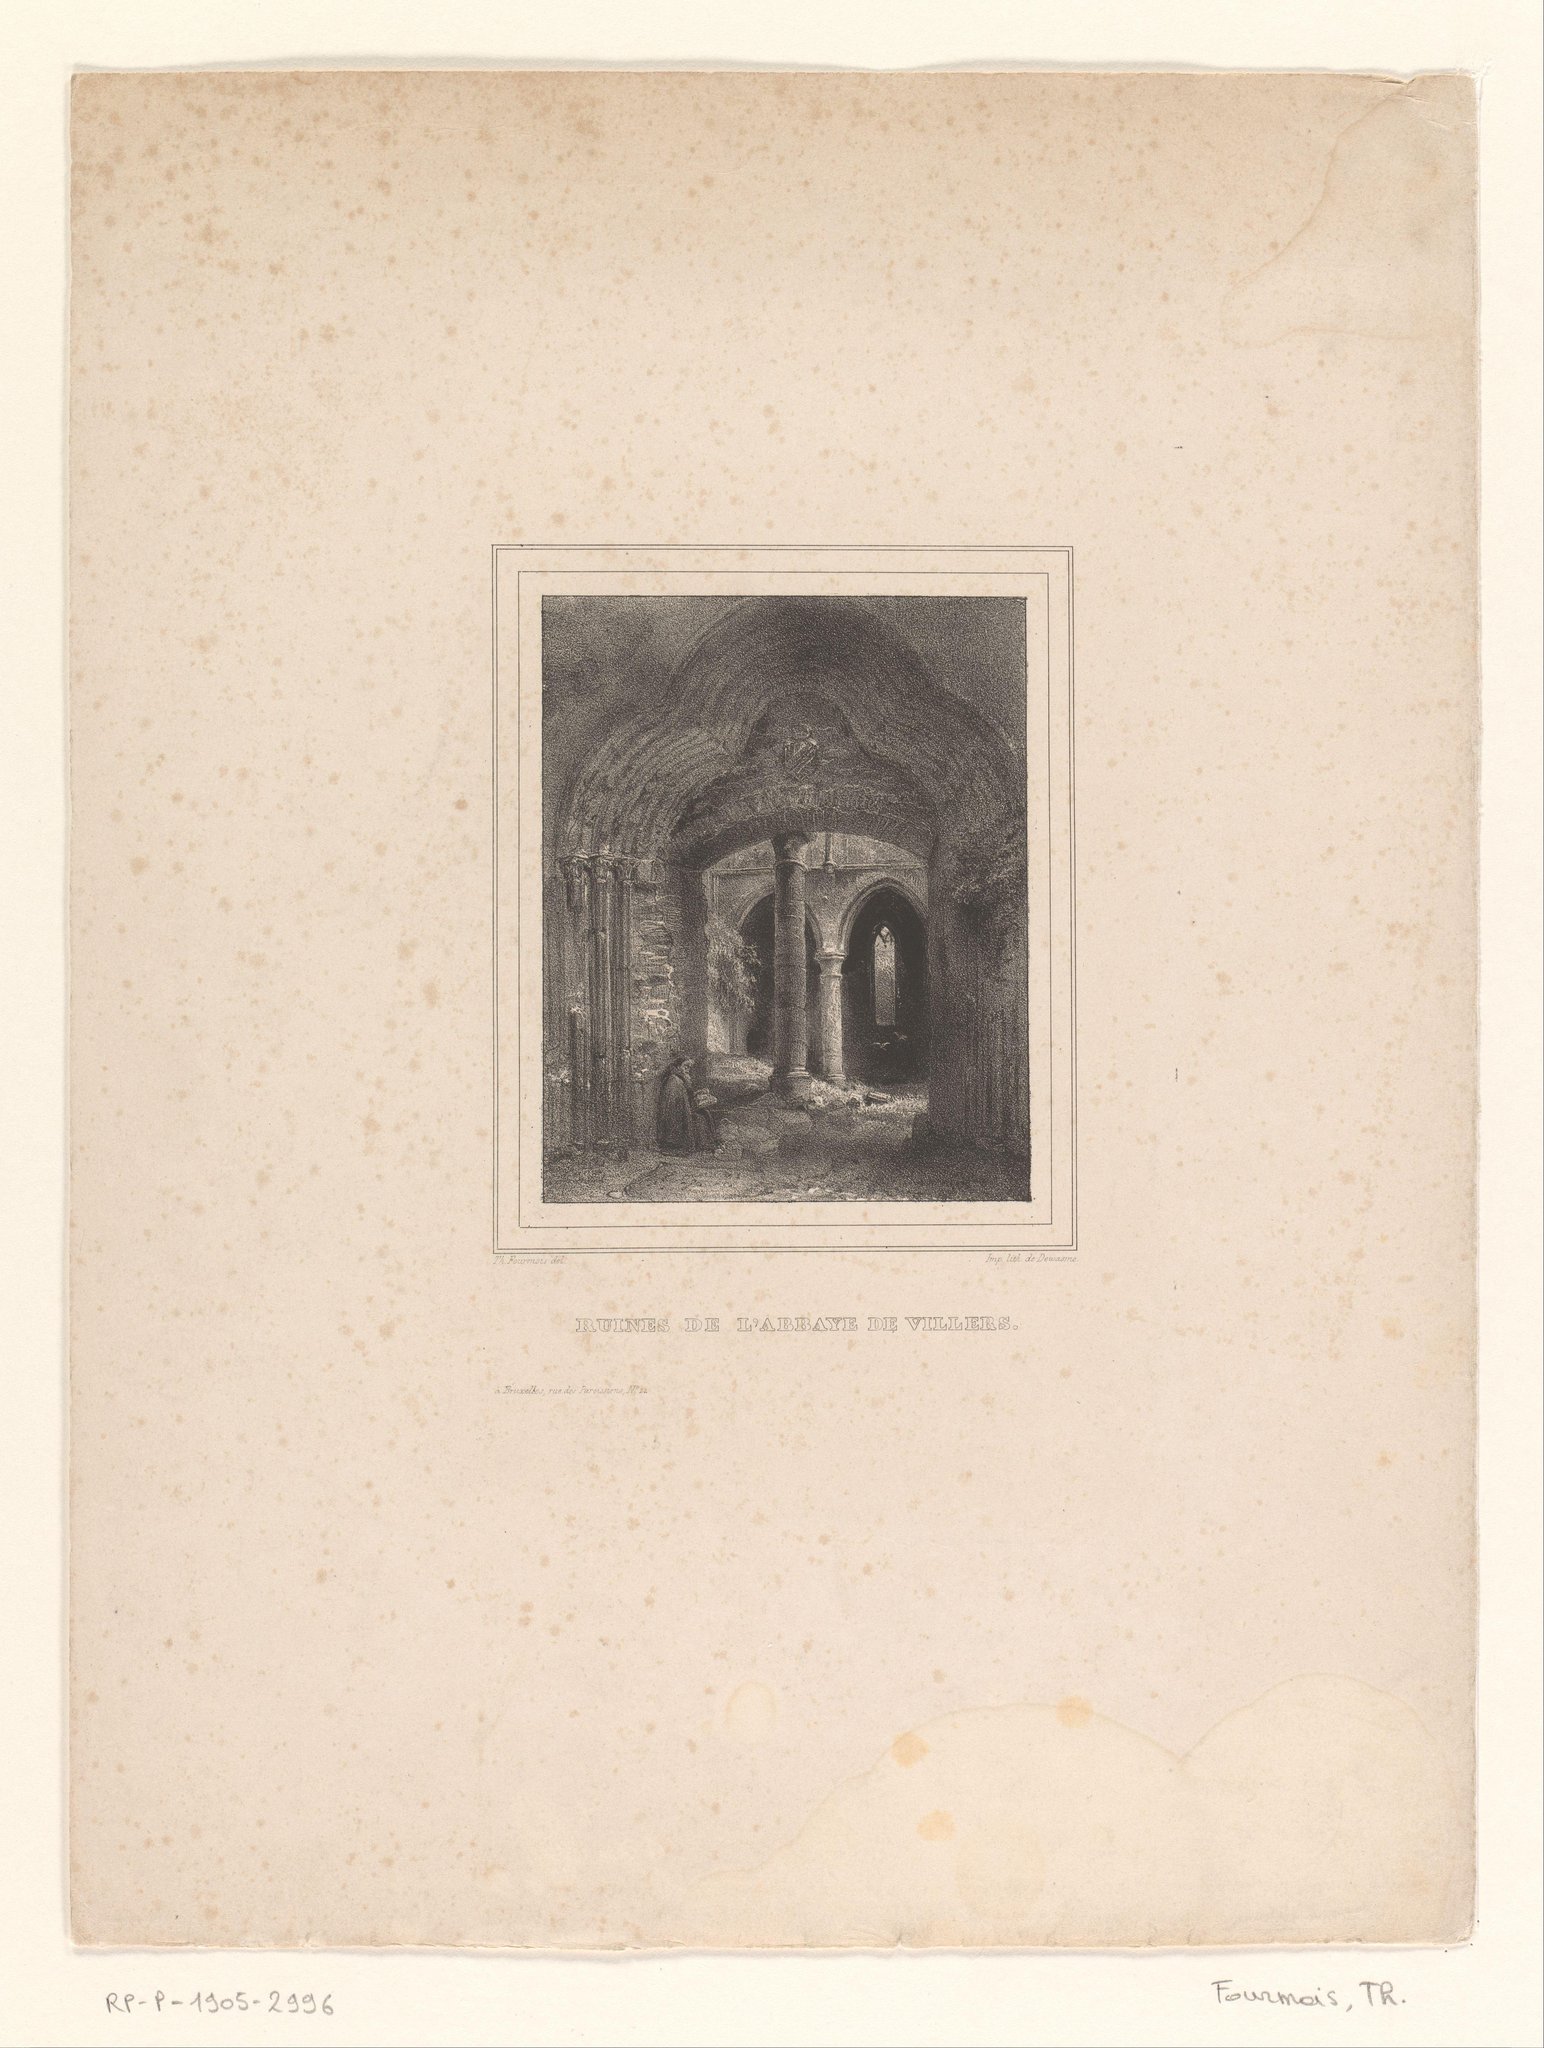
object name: print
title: Ruine de l'abbaye de Villers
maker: lith. de la cour des ps. bas à bruxelles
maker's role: printer, publisher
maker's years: 1797-1851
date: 1825-1827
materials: paper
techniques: lithograph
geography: brussels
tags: abbey, monastery, convent ~ roman catholic church, landscape with ruins, ruin of church, monastery, etc.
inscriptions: collector's mark: Lugt 2228